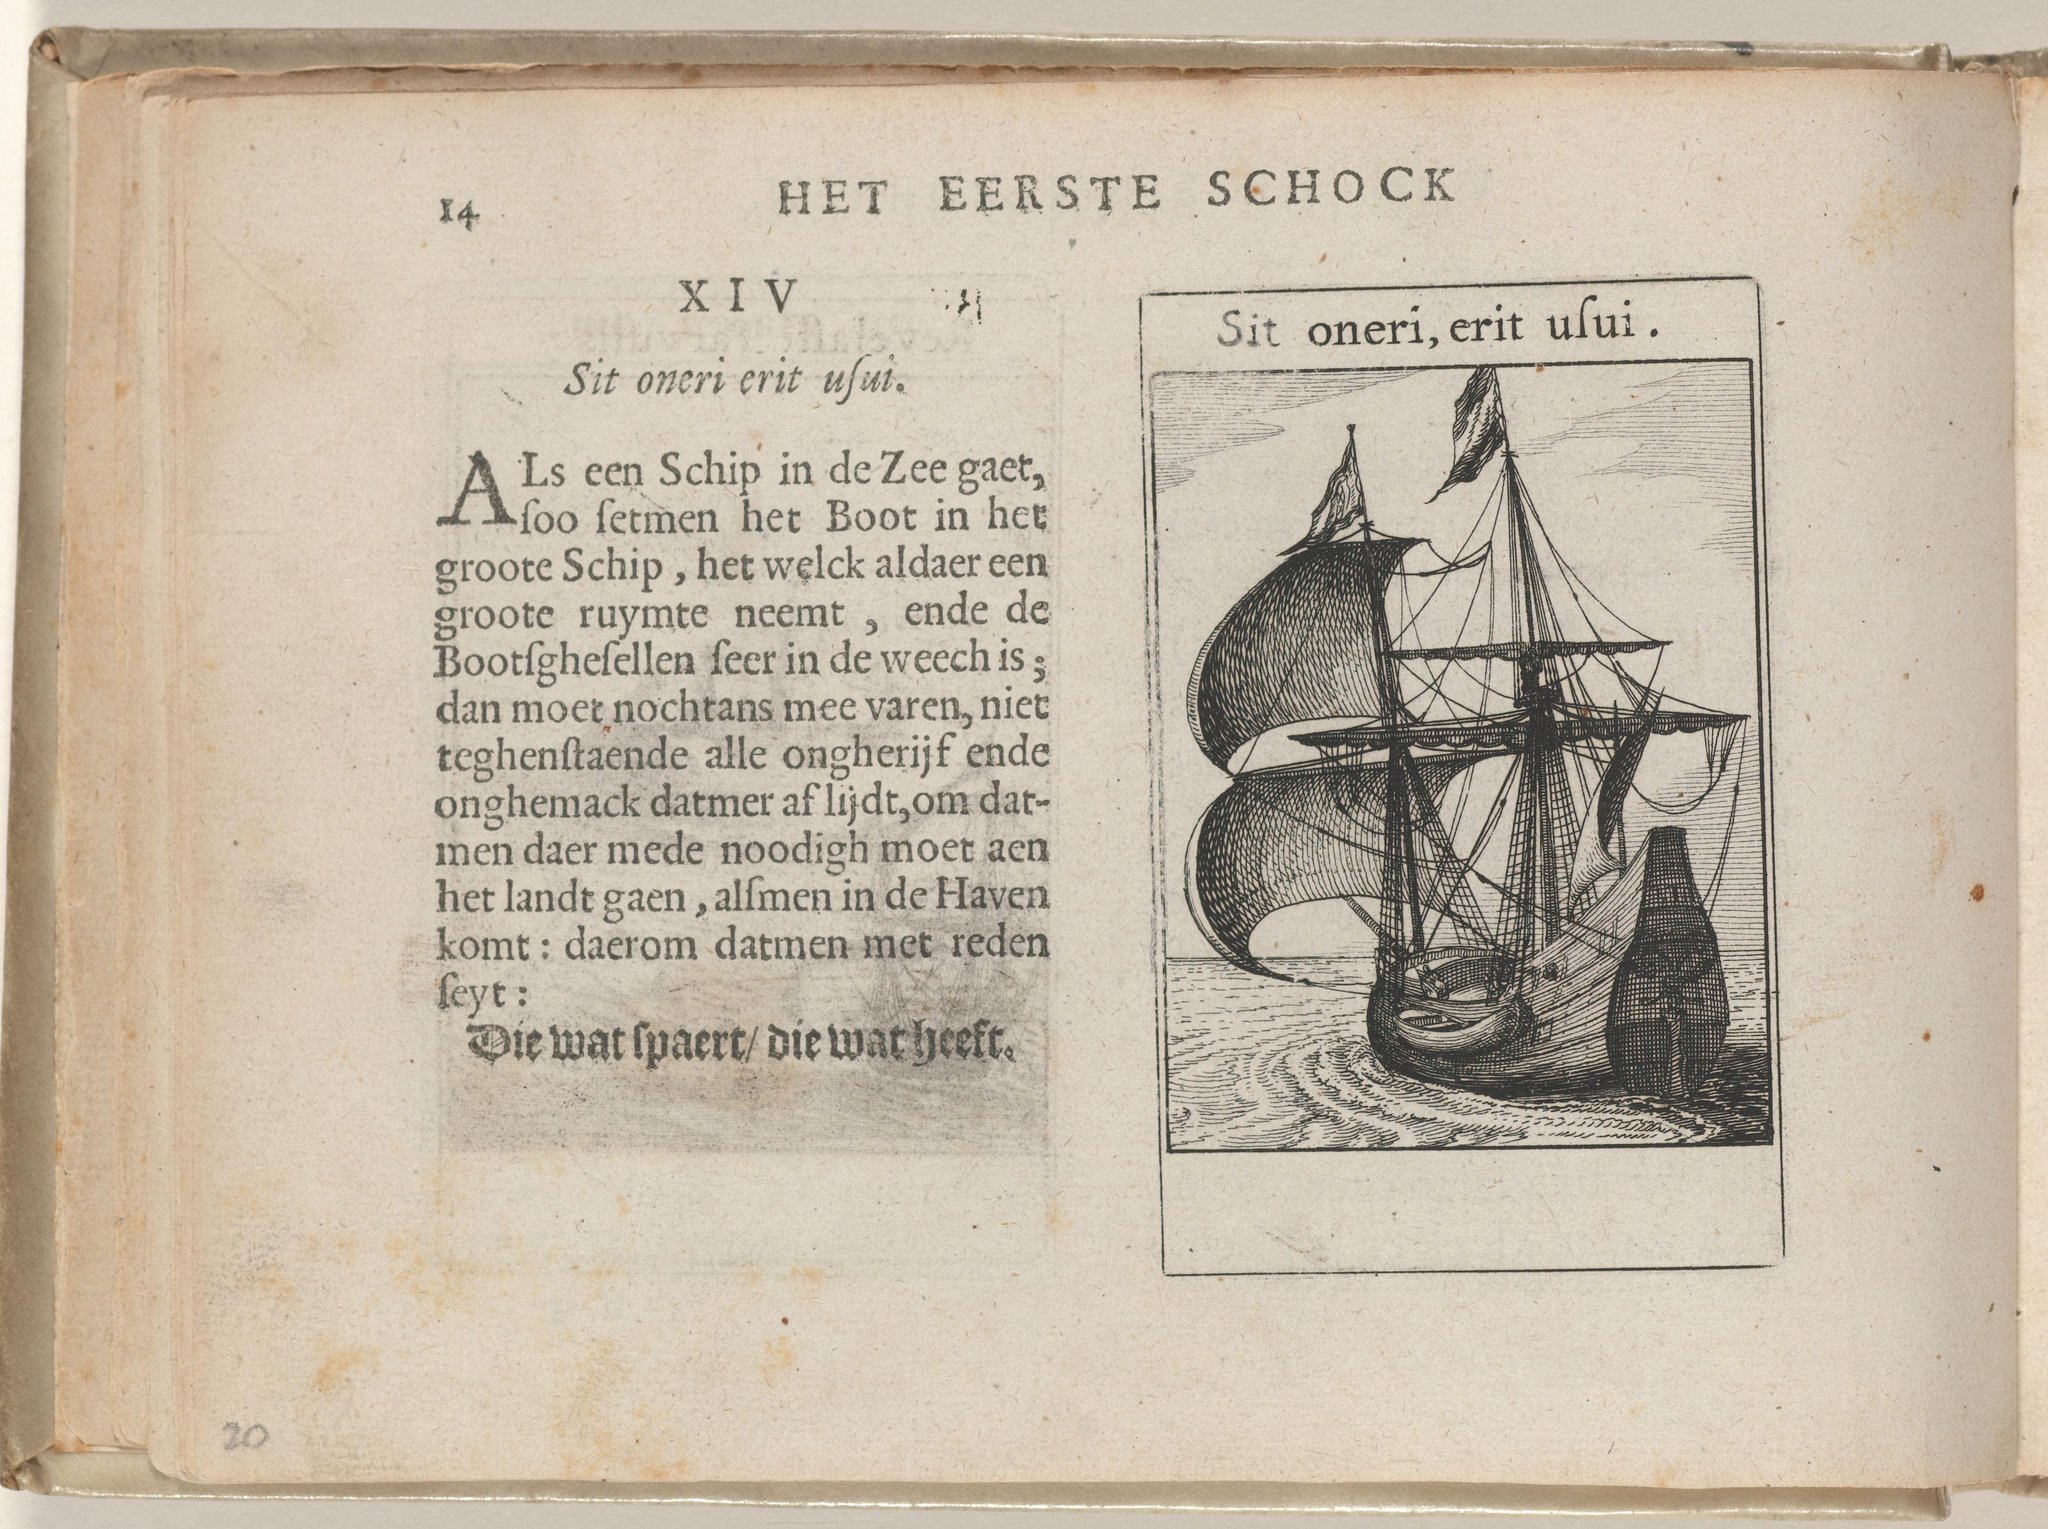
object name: album leaf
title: XIV Sit oneri, erit usui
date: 1614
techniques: engraving, printing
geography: the hague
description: XIV Sit oneri, erit usui. Eerste schok. Onderdeel van 'Sinnepoppen', R. Visscher, 1614.